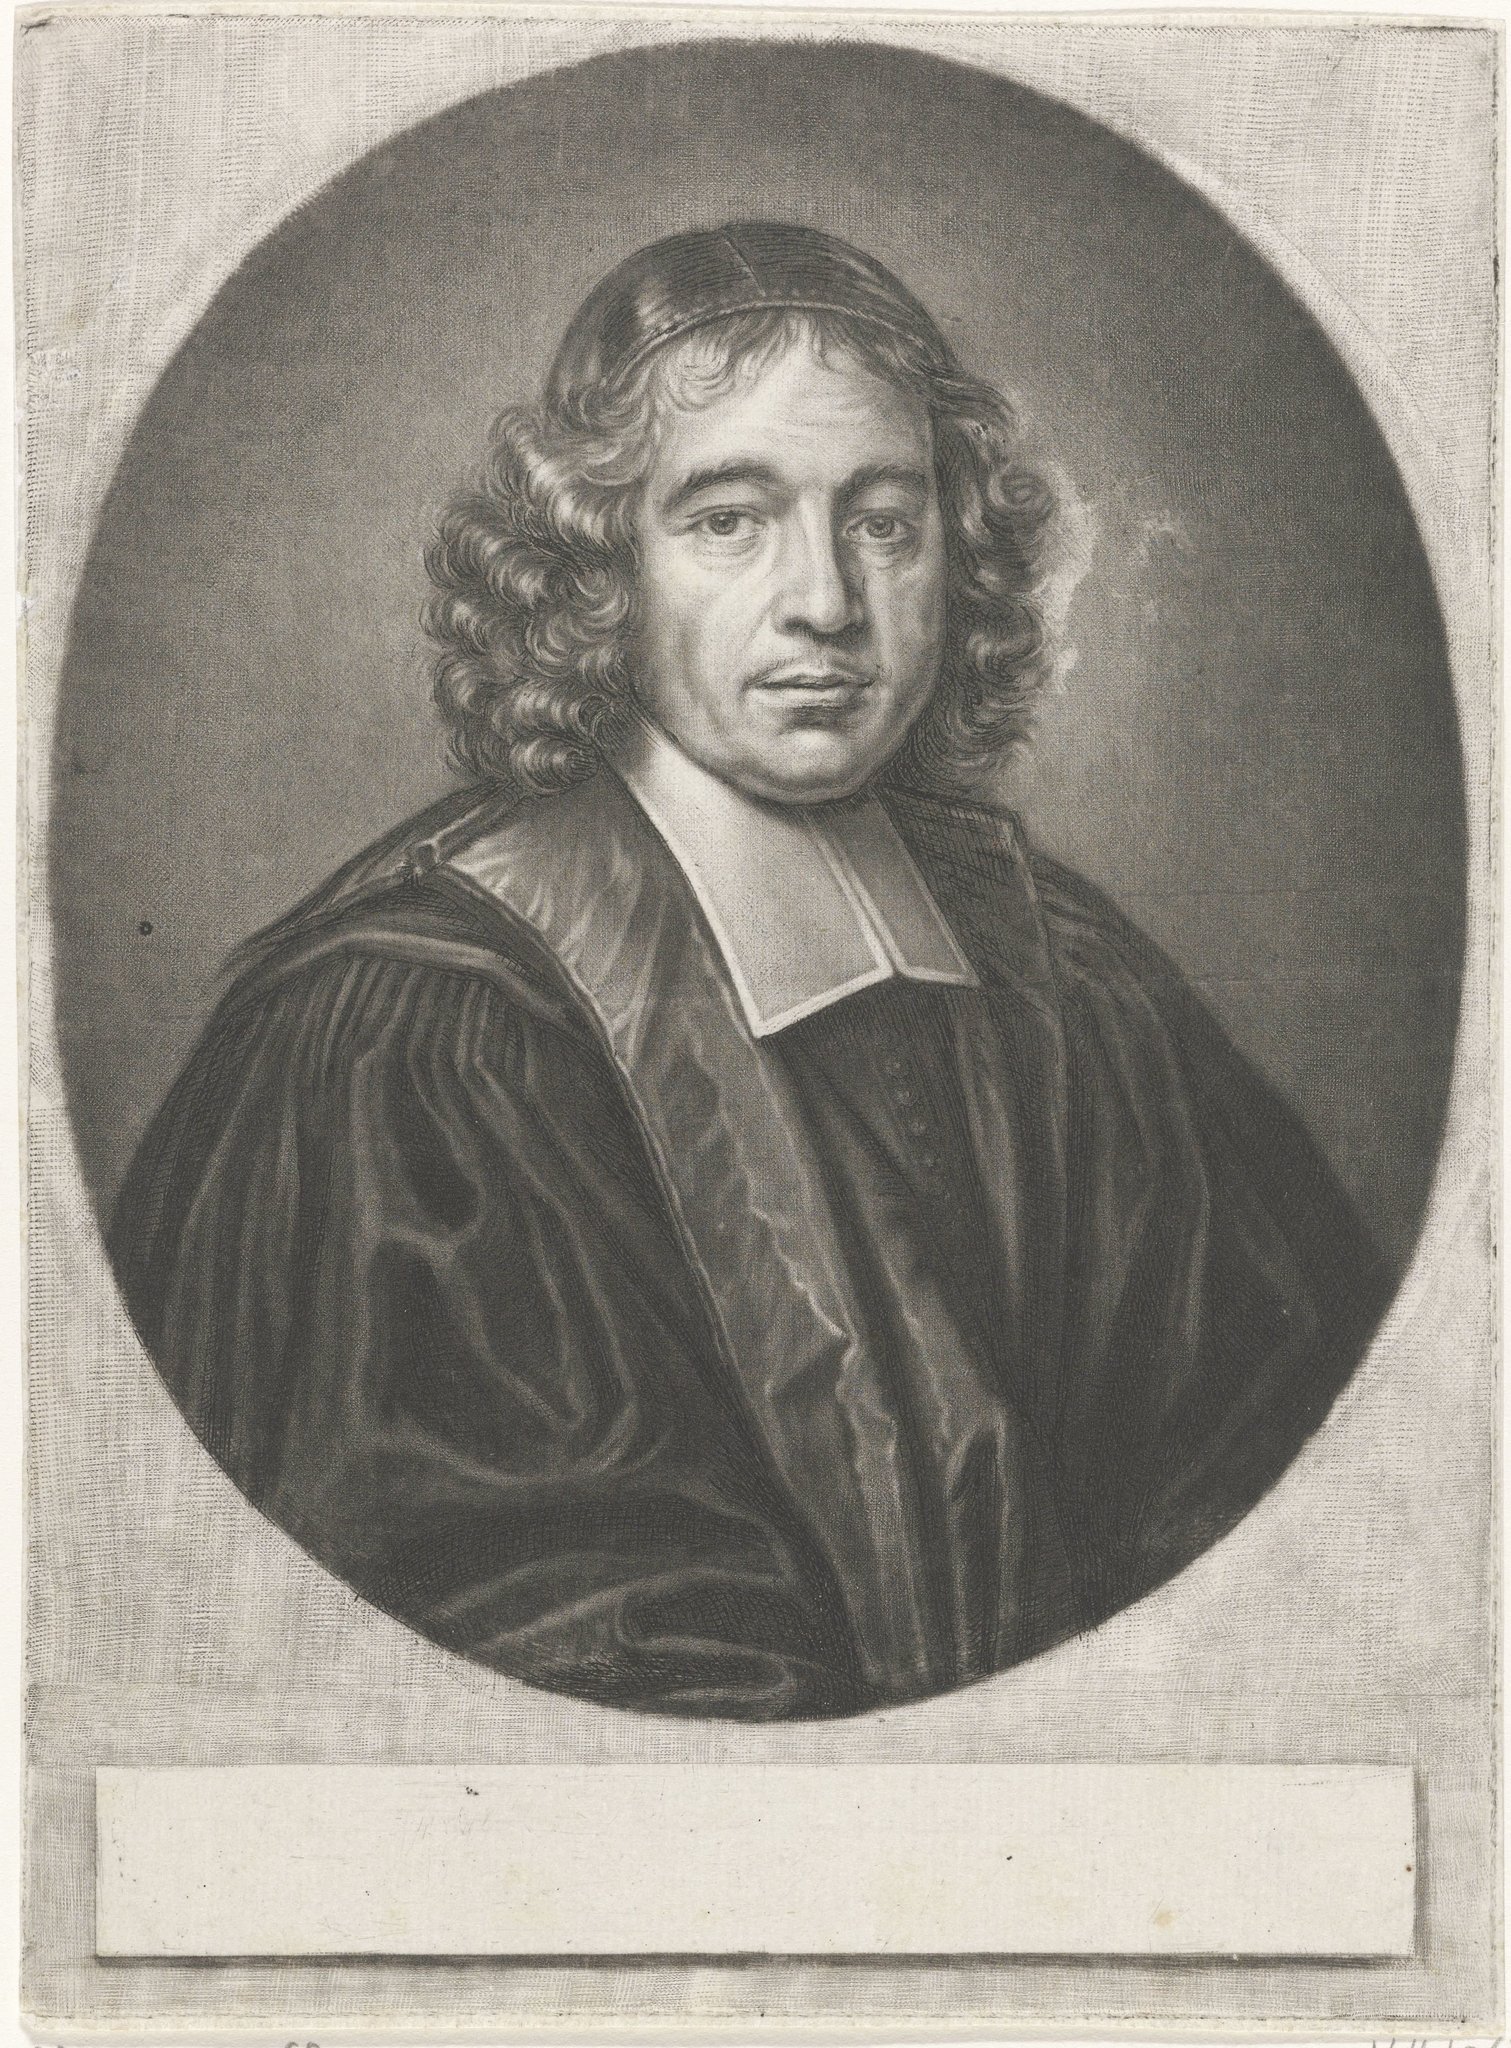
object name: print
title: Portret van Pierre Jurieu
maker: jacob gole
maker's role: print maker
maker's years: 1660-1724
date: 1670-1724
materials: paper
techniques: mezzotint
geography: amsterdam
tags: rotterdam, theologian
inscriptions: collector's mark: Lugt 2228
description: Pierre Jurieu, professor en predikant van de Waalse gemeente te Rotterdam.